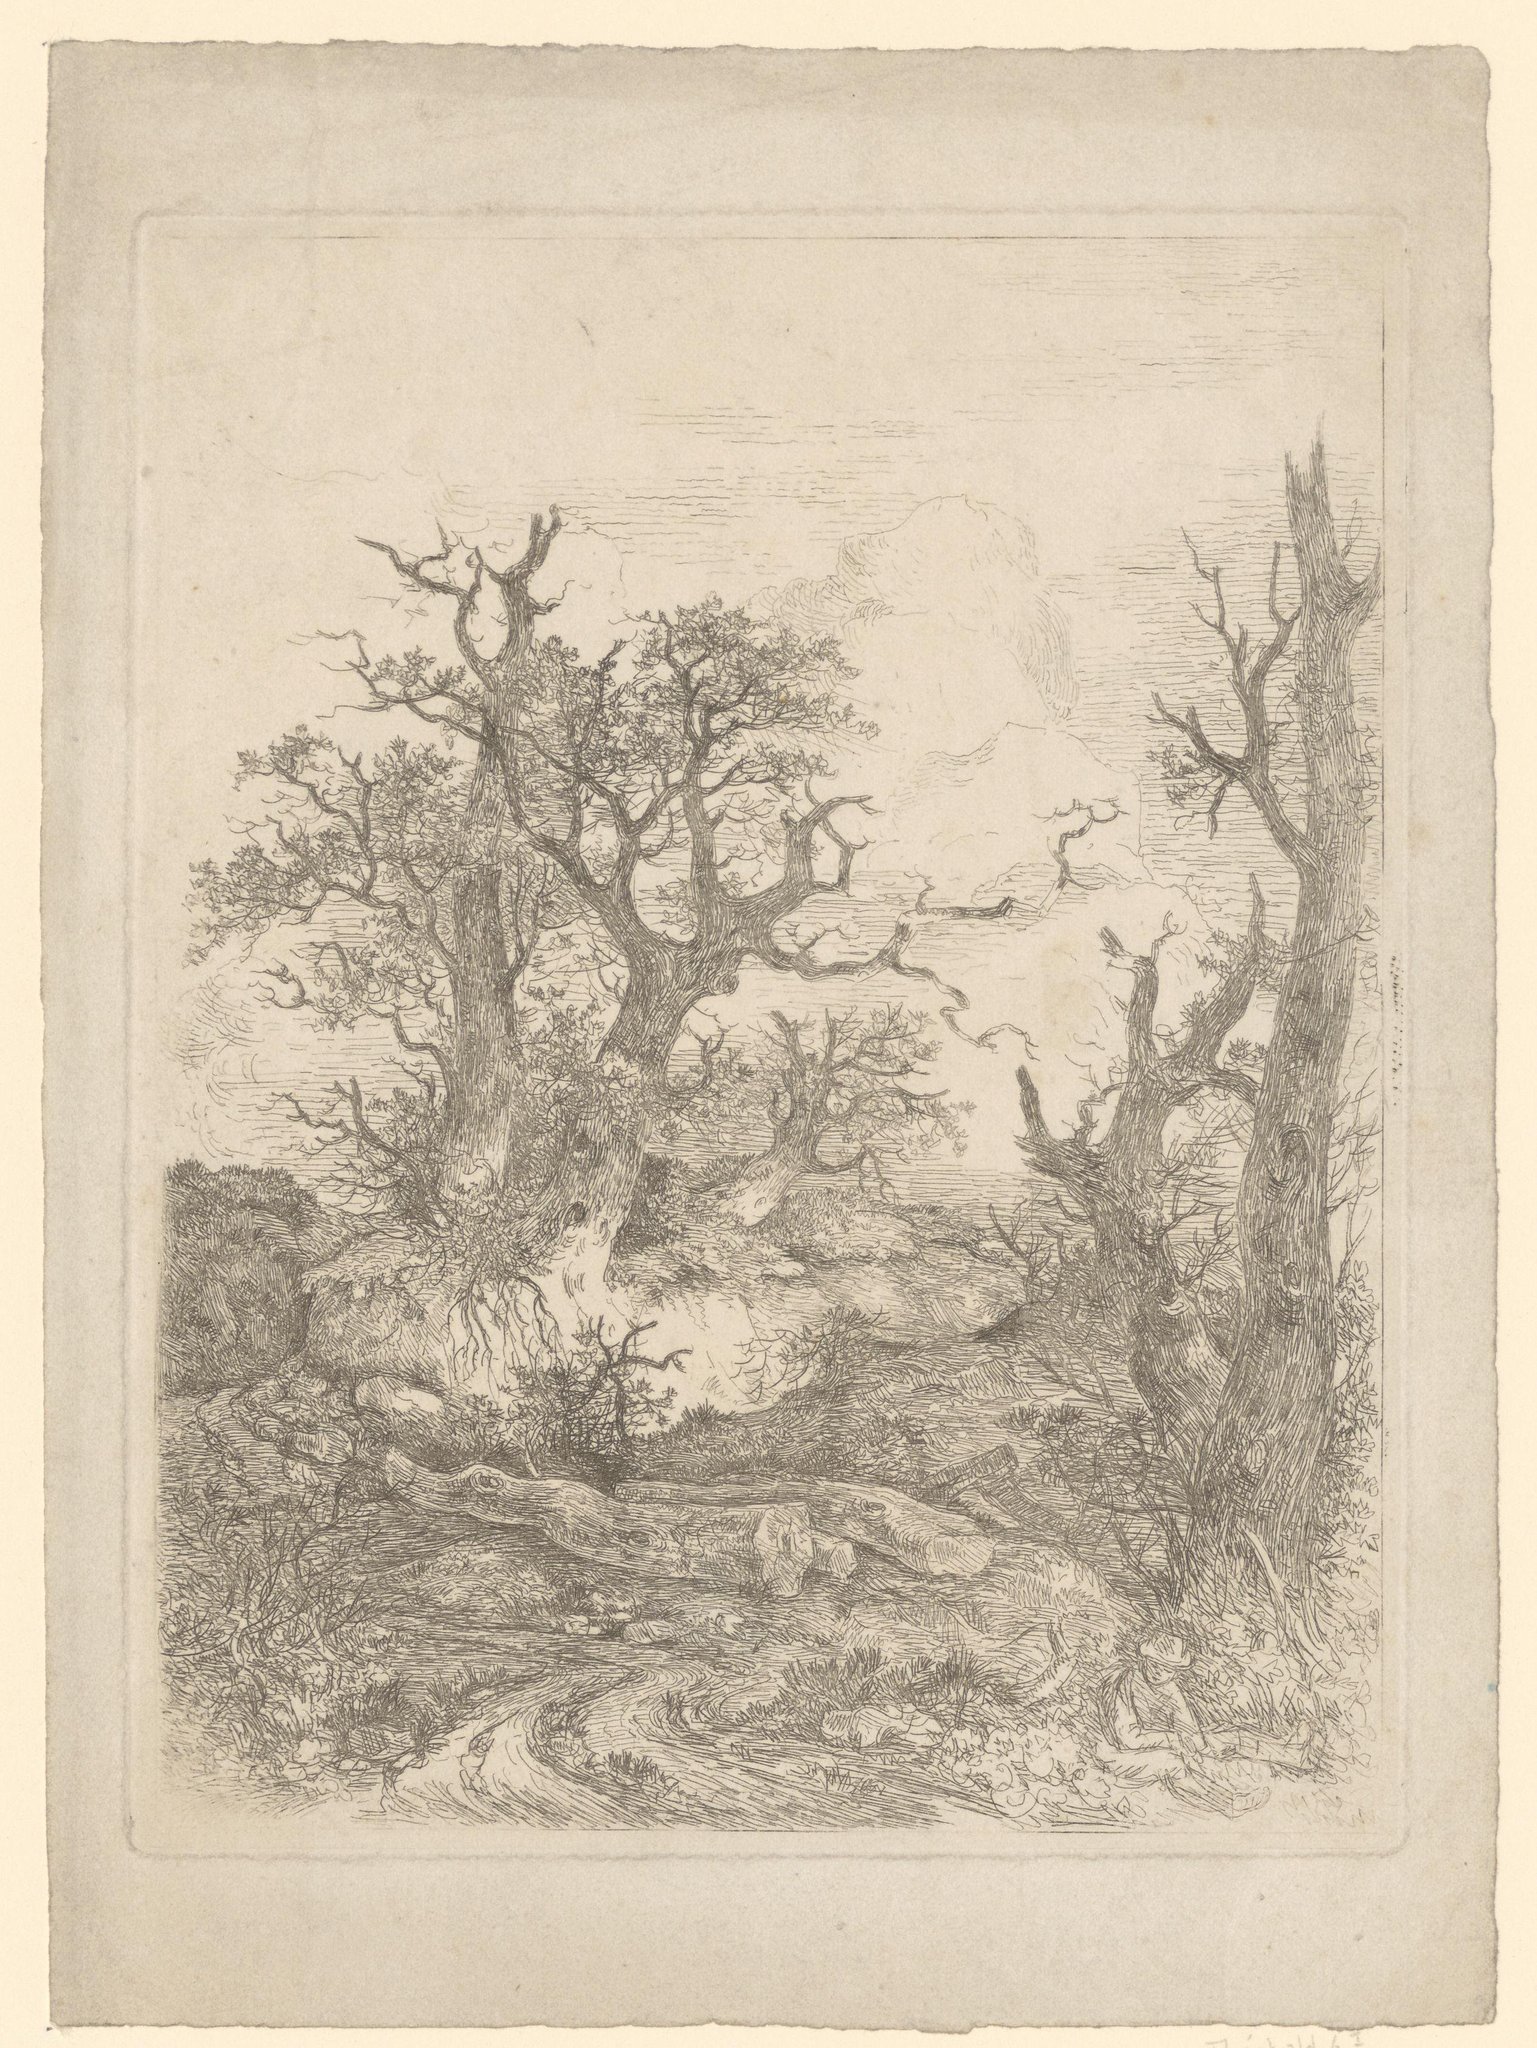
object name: print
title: Gravel Pit, Marlingford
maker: john crome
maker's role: print maker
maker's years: 1768-1821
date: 1811-1812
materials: paper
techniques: etching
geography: norwich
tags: trees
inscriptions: collector's mark: Lugt 2228, collector's mark: Lugt 2760